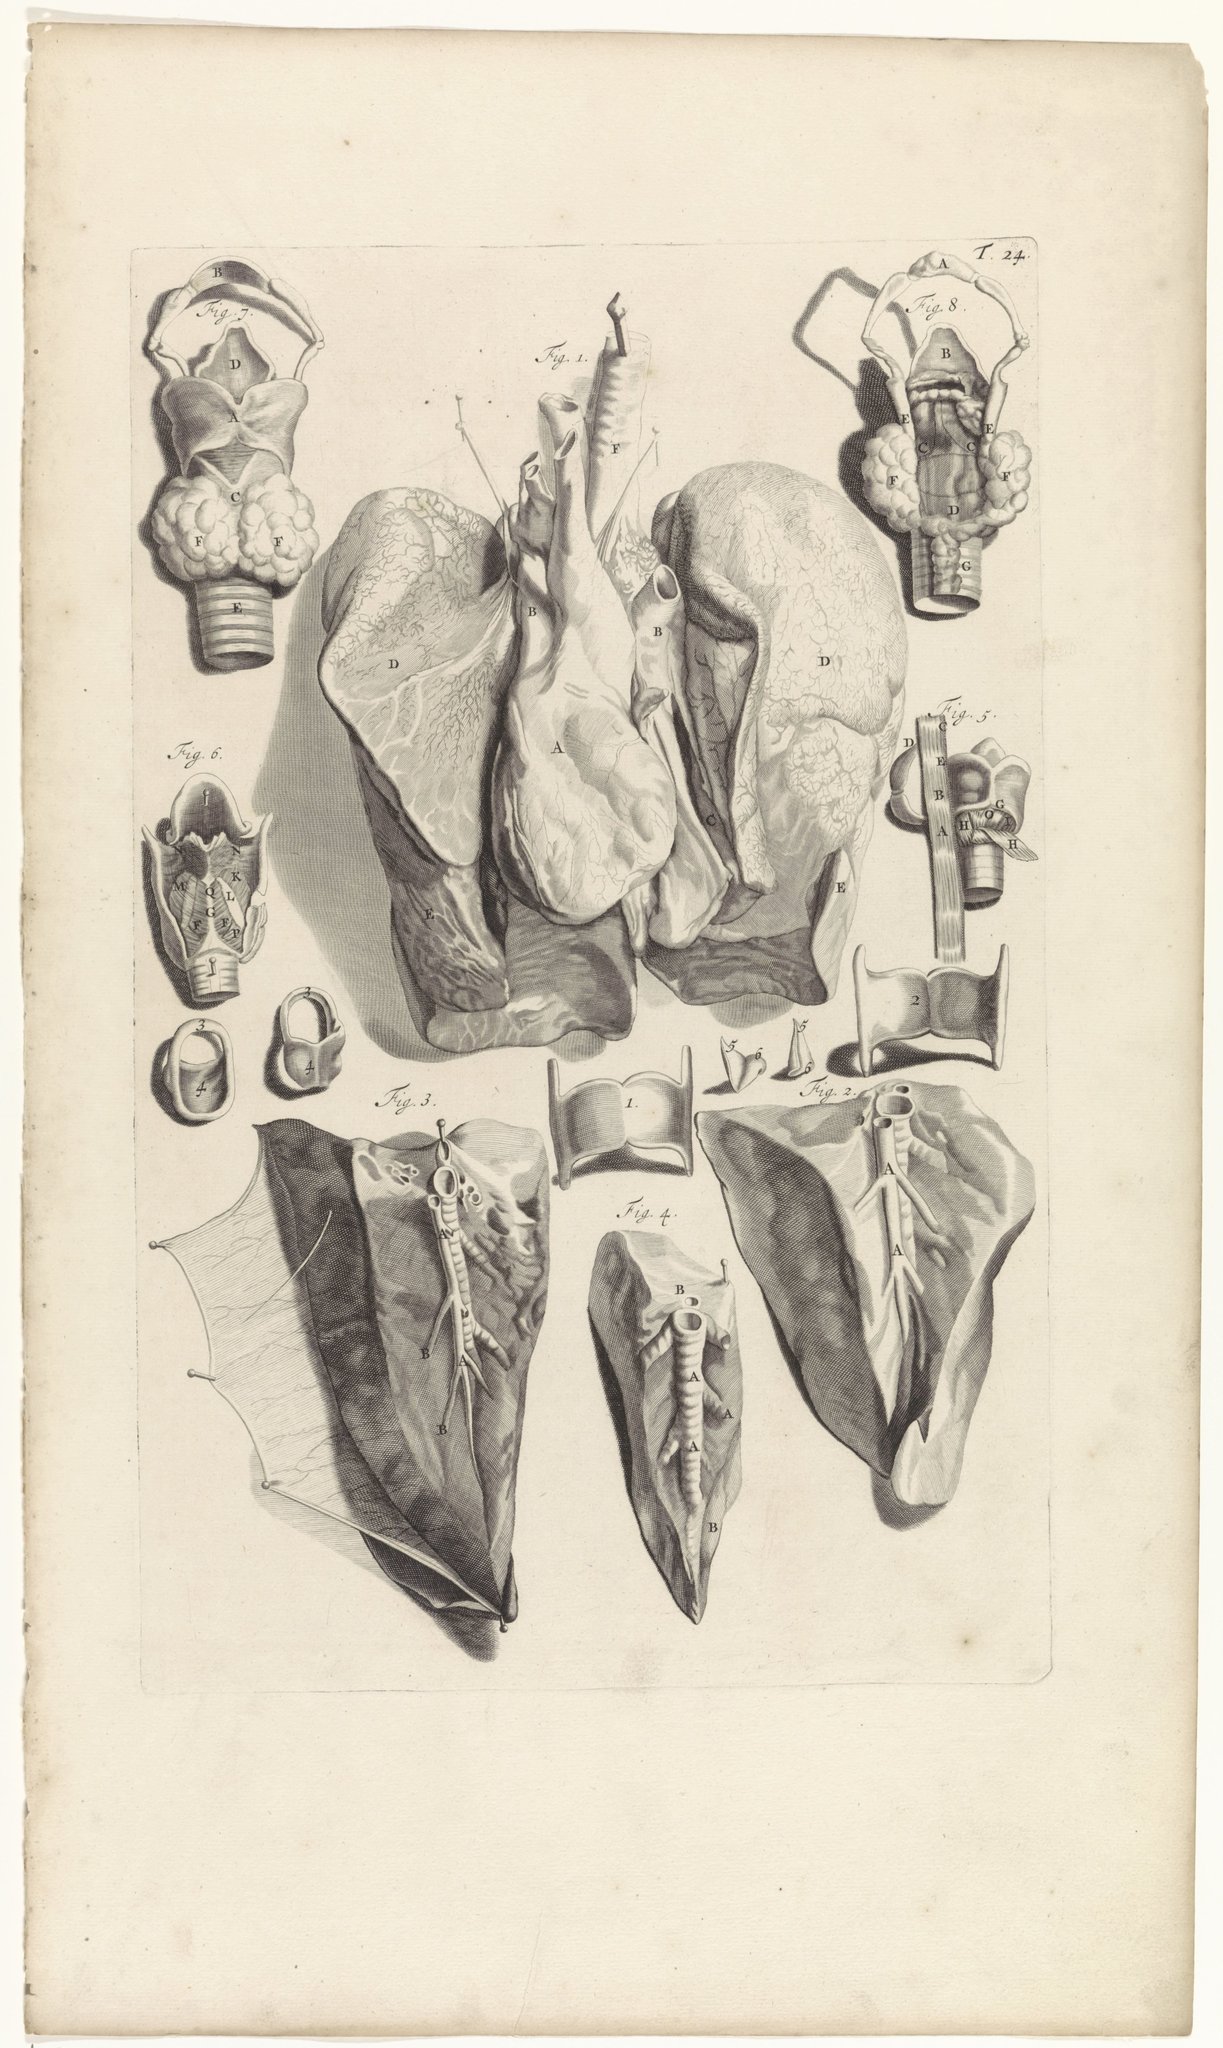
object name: print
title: Anatomische studie van de longen en het strottenhoofd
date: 1685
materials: paper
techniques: engraving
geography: amsterdam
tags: lungs, bronchia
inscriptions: collector's mark: Lugt 2228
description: Boekillustratie voor Bidloo, Godefridus. Anatomia humani corporis centum & quinque tabulis, per art. G. de Lairesse ad vivum delineatis, de monstrata, veterum recentiorumque inventis explicata plurimisque, hactenus non detectis, illustrata. Amsterdam: Weduwe Joannes van Someren, Hendrick Boom en erven Dirk Boom, 1685.